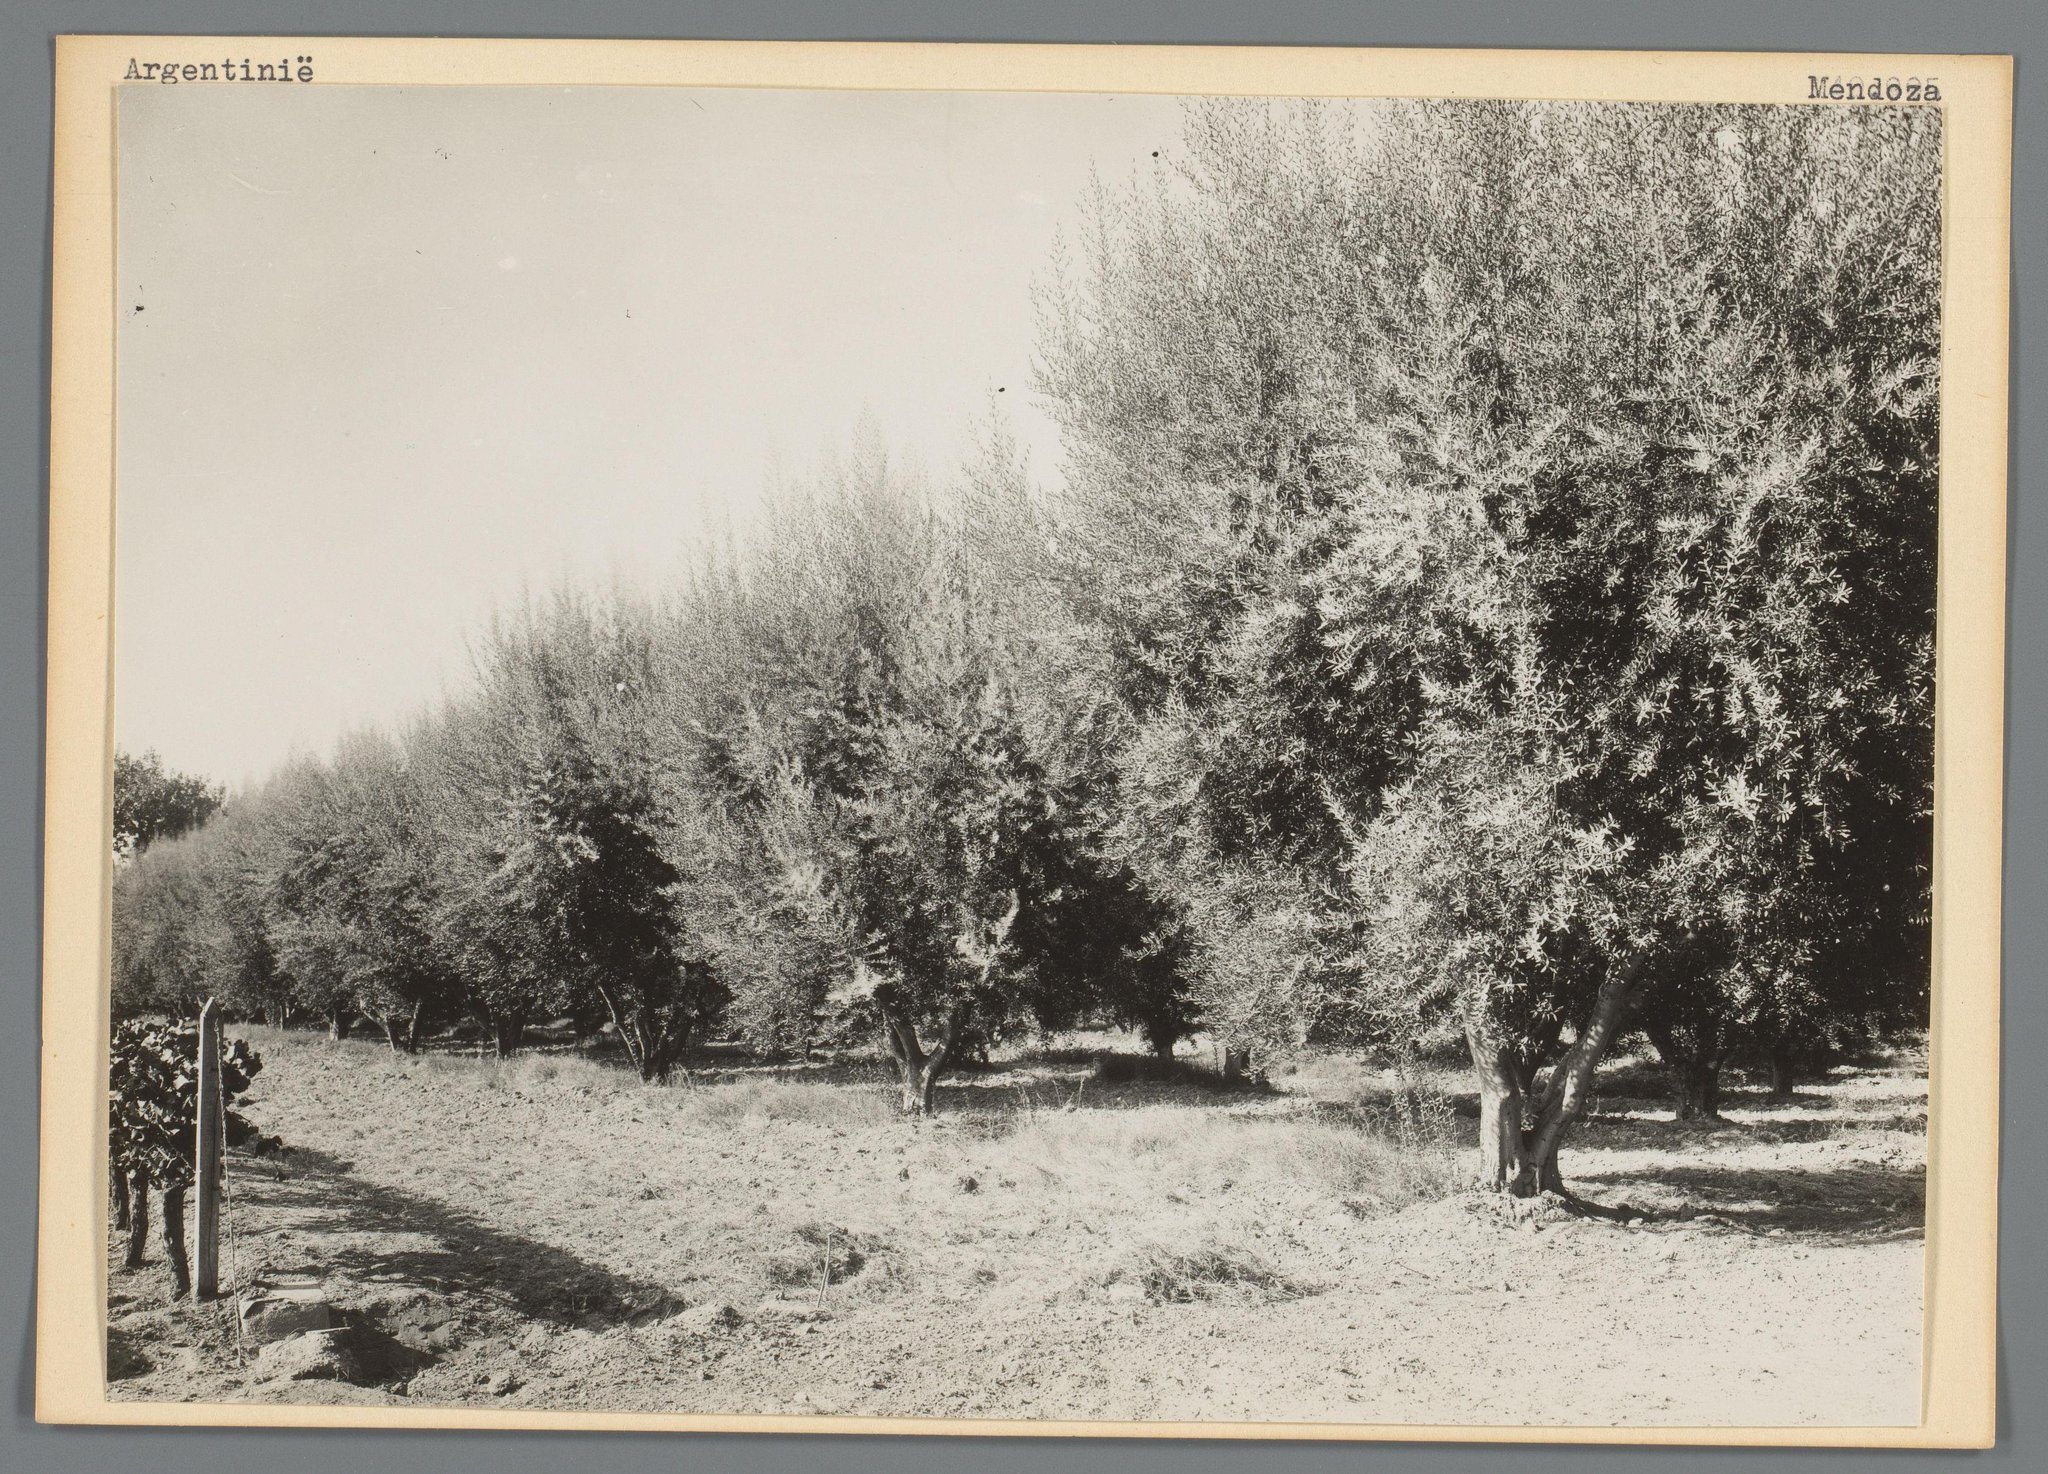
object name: photograph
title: Gezicht op een boomgaard in Mendozo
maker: Anonymous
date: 1900-1930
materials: paper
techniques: gelatin silver print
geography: mendoza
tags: orchard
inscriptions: stamp: ‘REPÚBLICA ARGENTINA/ MINISTERIO D'AGRICULTURA DE LA MACIOR/ [...]/ DIVISION FOTO-CINEMATOGRAFIA’, number: ‘970000’, inscription: ‘Escuela Nacional Vitivinícola de Mendoza. Olívar variedad Piñoa. (1)/ (1) Ecole Nationale de viticulture à la Province de "Mendoza"(Olivette)’, inscription: ‘Escuela Nacional Vitivinicola de Mendoza (Provincienaam)’, number: ‘40.905’, number: ‘1124.’